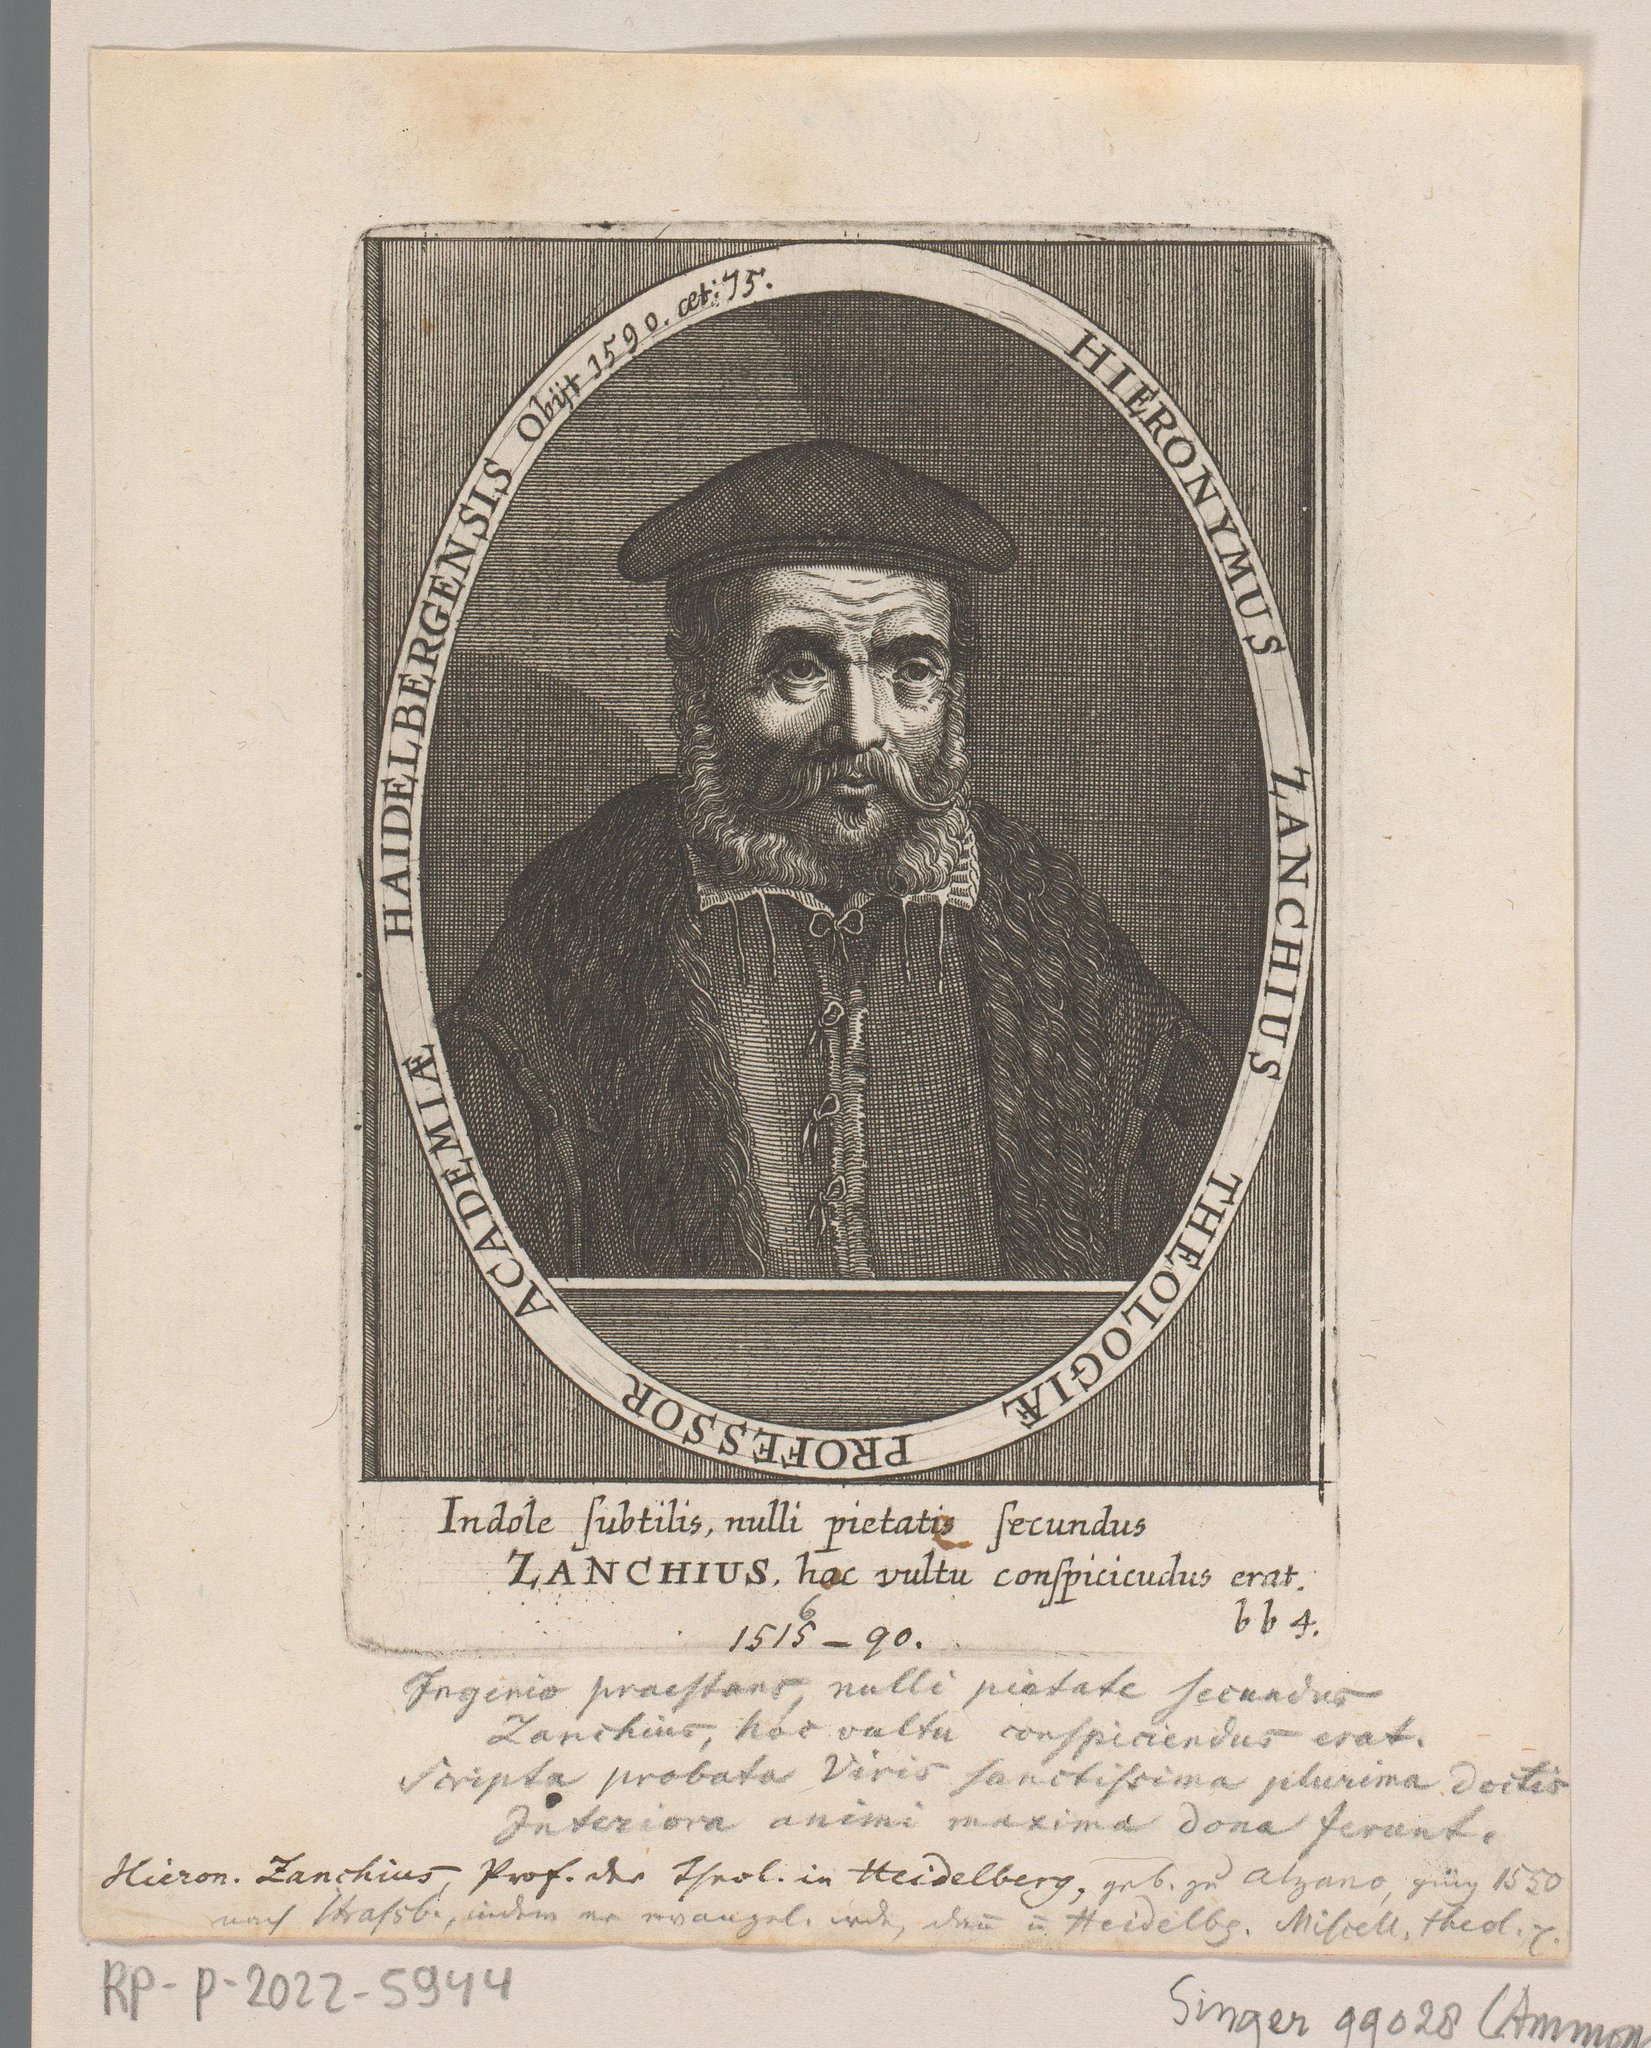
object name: print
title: Portret van Hieronymus Zanchius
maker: Anonymous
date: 1669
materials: paper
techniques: engraving, etching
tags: reformation (roman catholic church vs. protestantism), theologian, historical persons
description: Rechtsonder: bb4. Met handgeschreven onderschrift in het Nederlands.